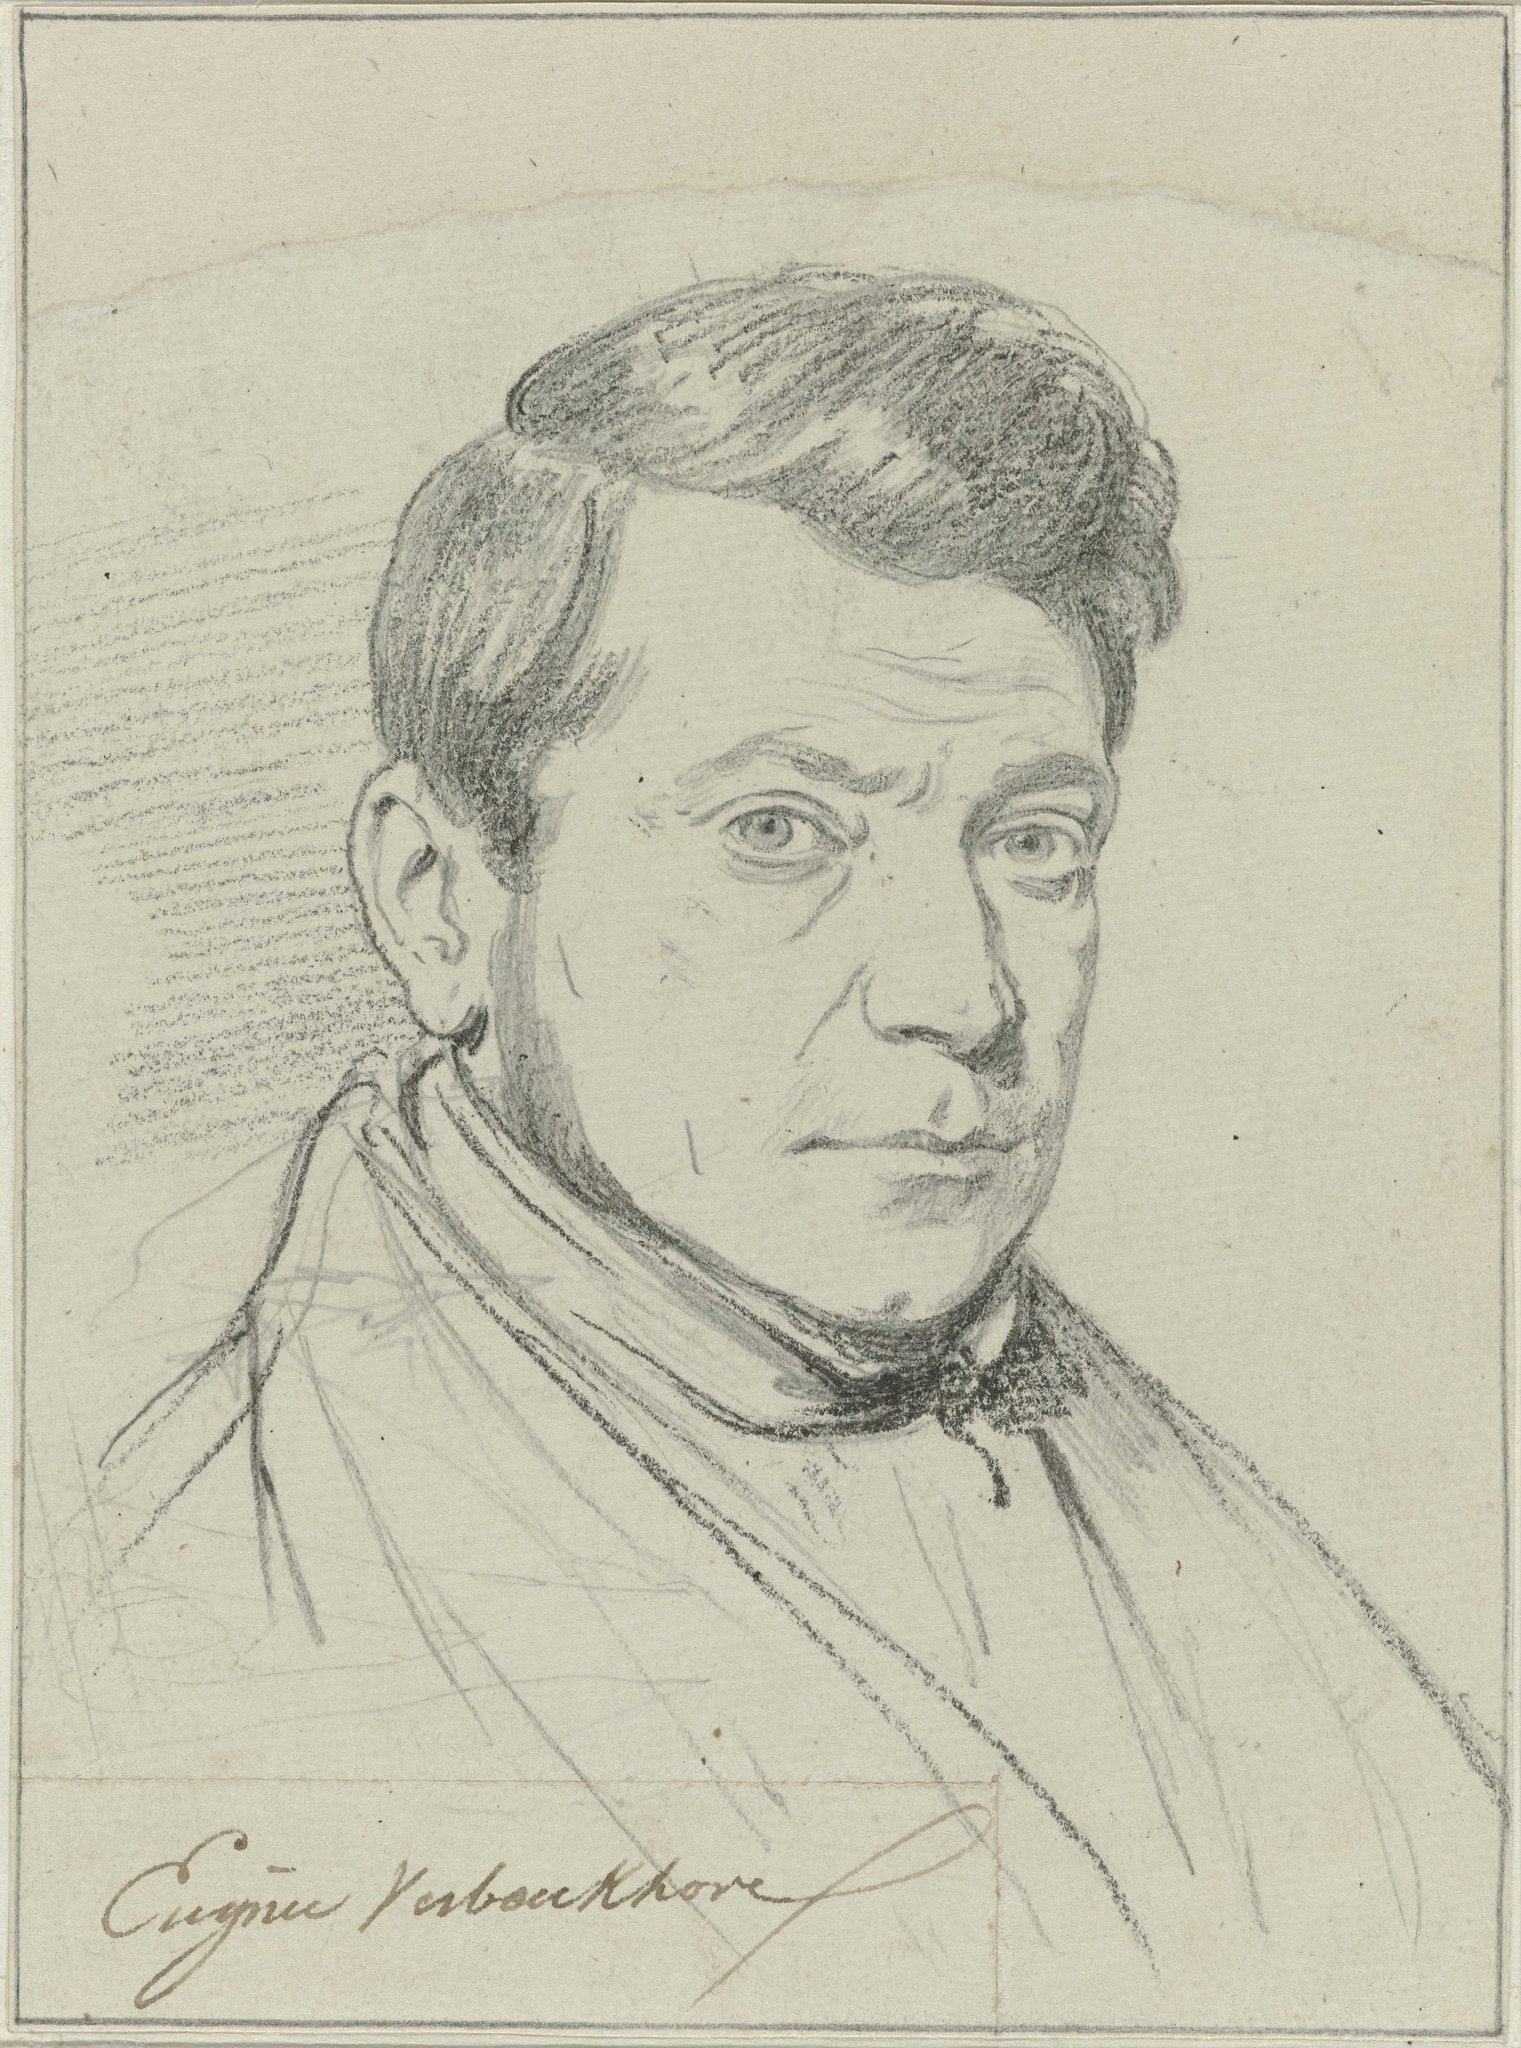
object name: drawing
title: Zelfportret van Eugène Verboeckhoven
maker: eugène verboeckhoven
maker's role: draughtsman, painter, print maker, printer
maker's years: 1798-1881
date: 1808-1881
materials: chalk, paper, pencil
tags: print maker, eugène verboeckhoven, portrait, self-portrait of sculptor, historical persons, portrait, self-portrait of painter, portrait, self-portrait of artist, portrait, self-portrait of graphic artist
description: Zelfportret van de beeldhouwer, schilder en graficus Eugène Verboeckhoven.